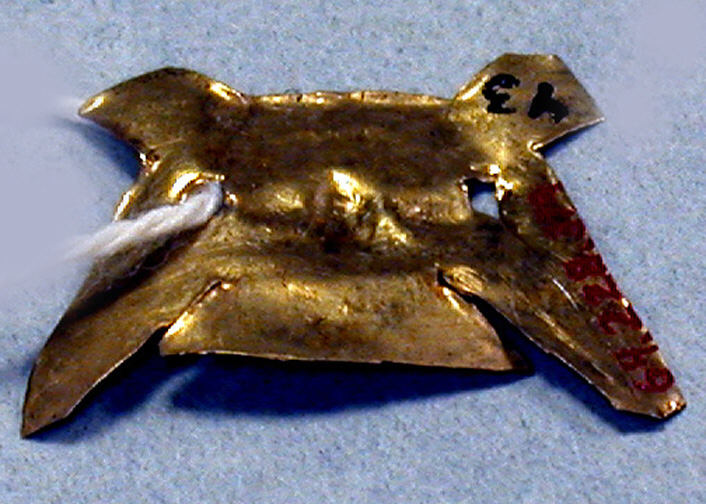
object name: ornament fragment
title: Hammered Gold Ornament Fragment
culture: peruvian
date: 200-900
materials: gold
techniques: hammering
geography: peru